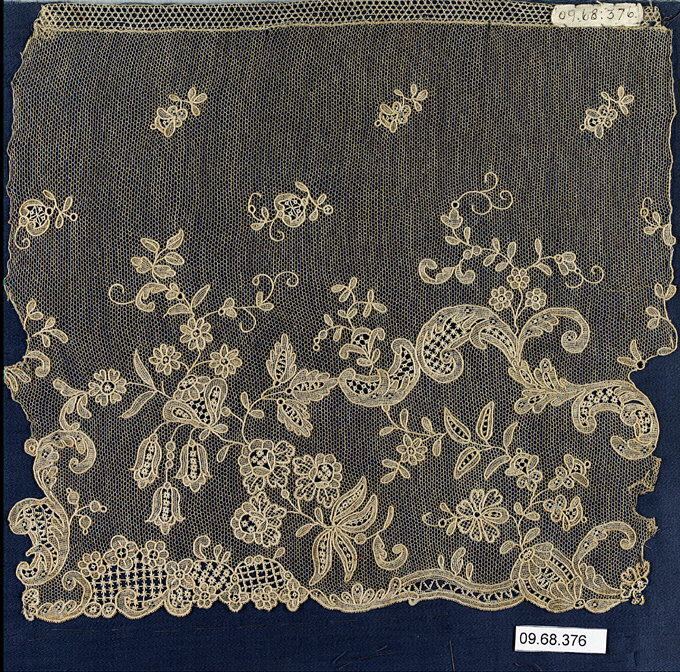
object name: fragment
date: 1801-1900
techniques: lace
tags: flowers,leaves